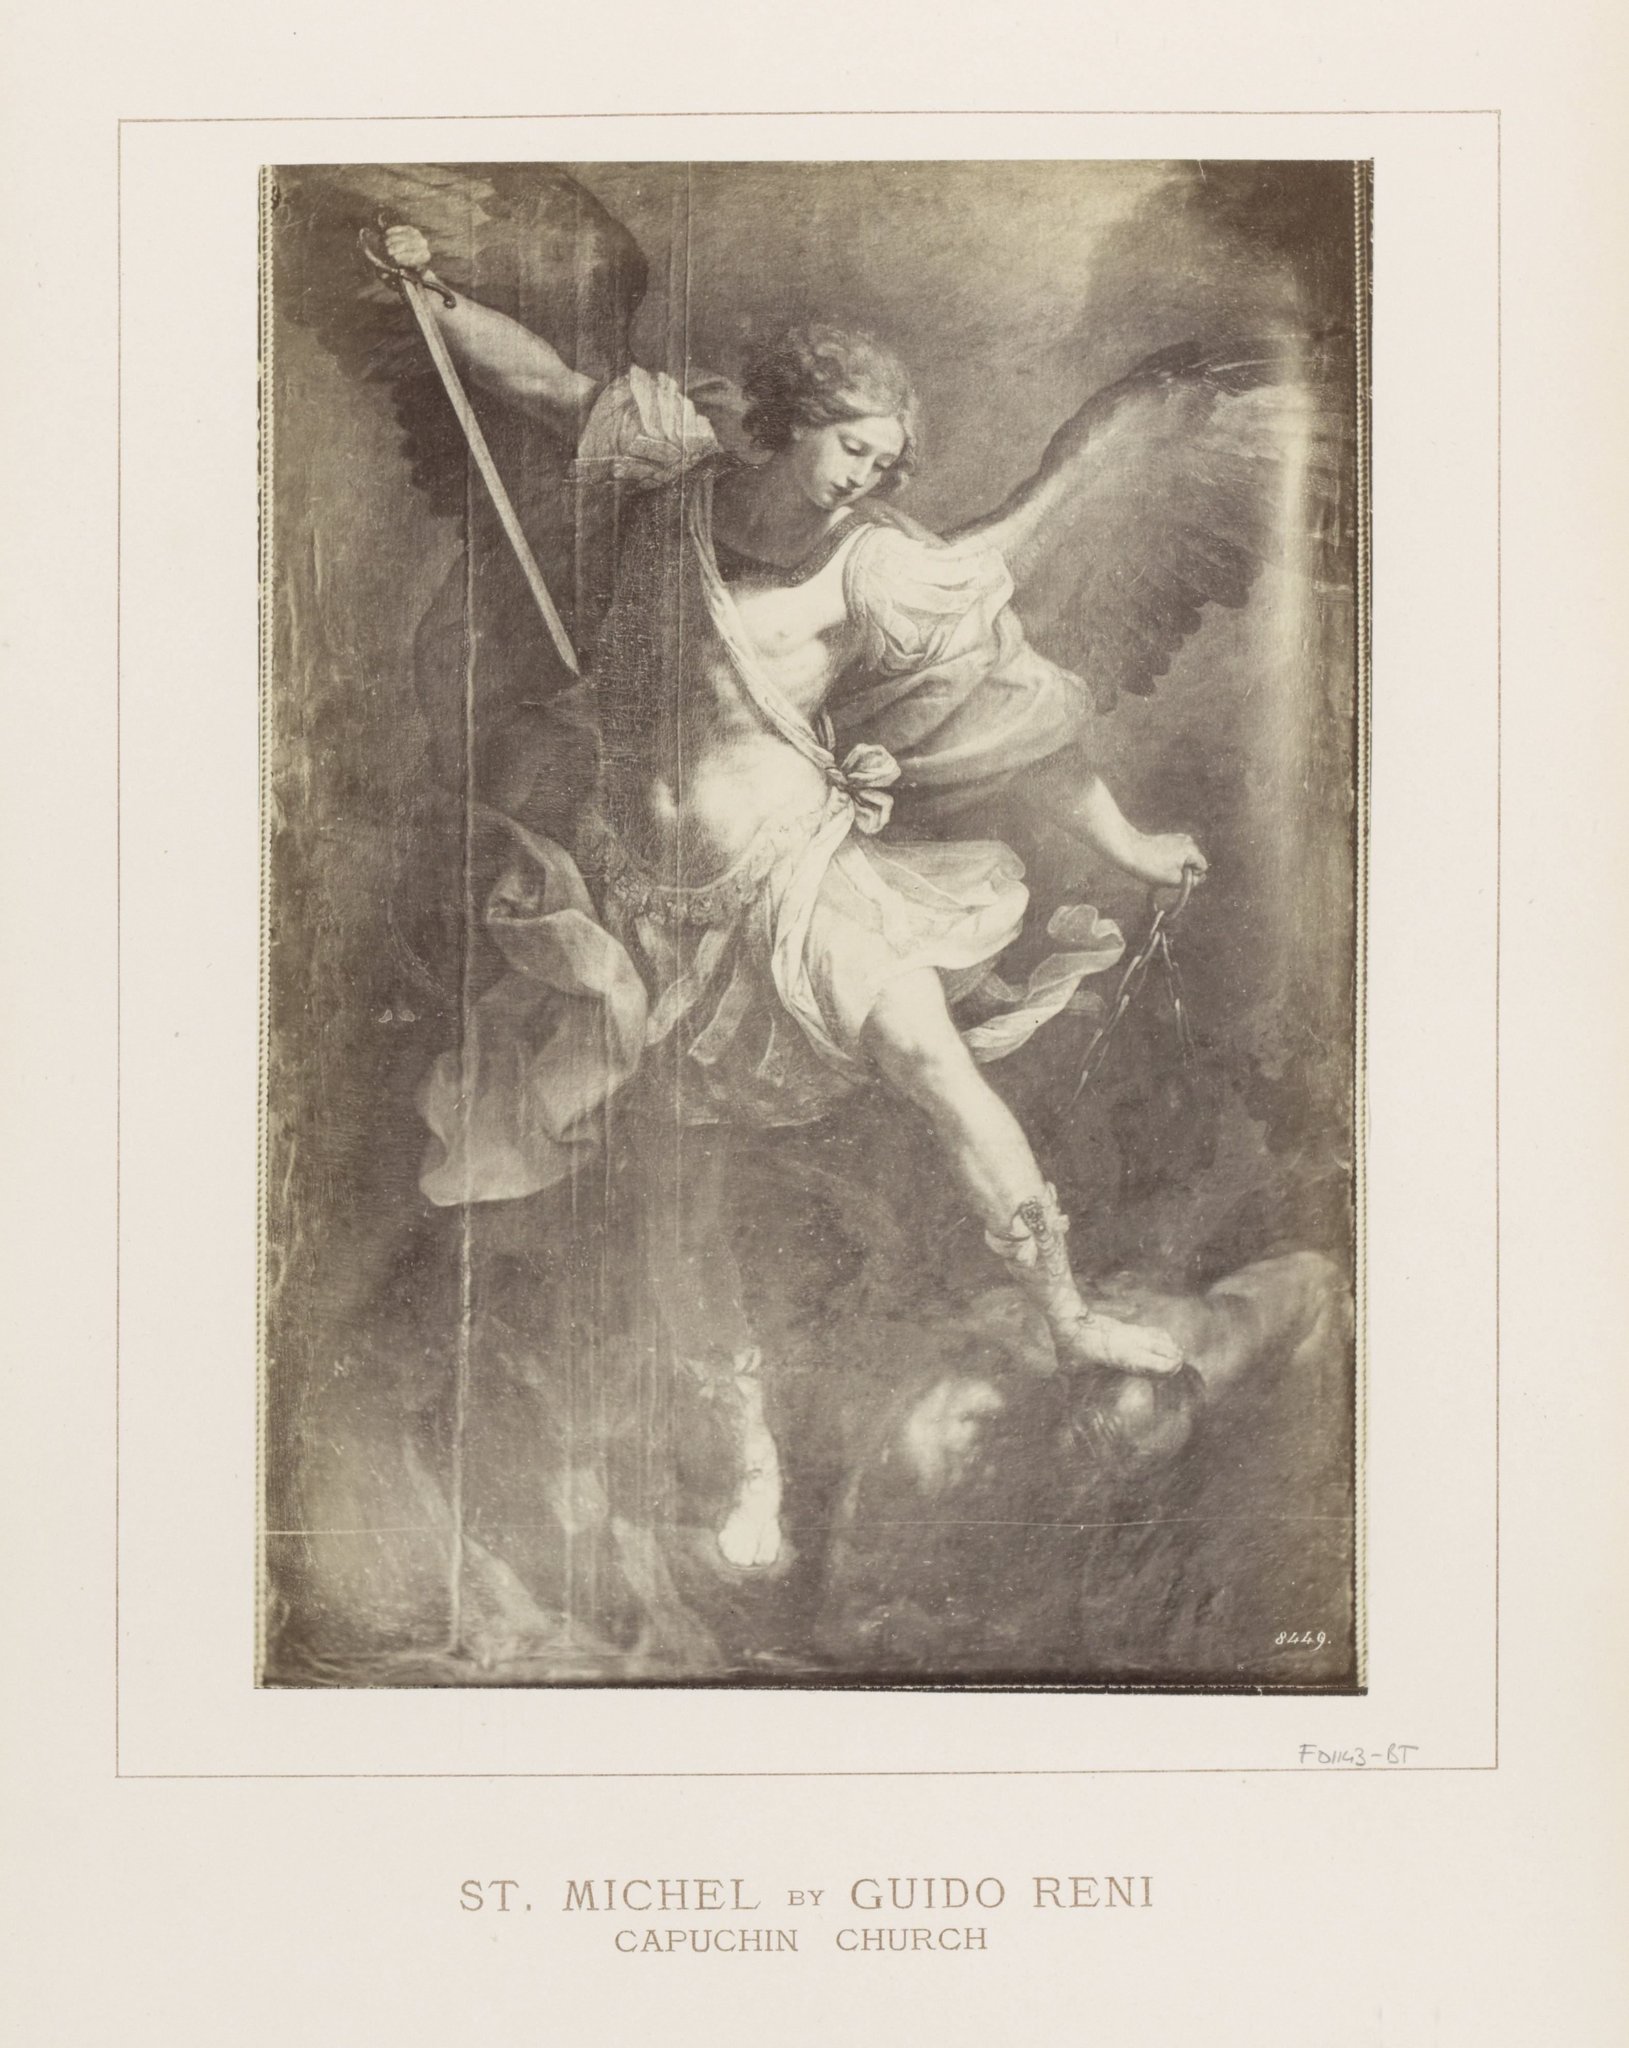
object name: photograph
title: Fotoreproductie van een schilderij door Guido Reni, voorstellend de aartsengel Michaël en satan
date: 1860-1900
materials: photographic support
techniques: albumen print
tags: the archangel michael fighting the dragon (devil, satan)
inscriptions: inscription: ‘Alinari’, number: ‘8449’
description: Onderdeel van Fotoalbum met opnames van bezienswaardigheden en kunstwerken in Rome.